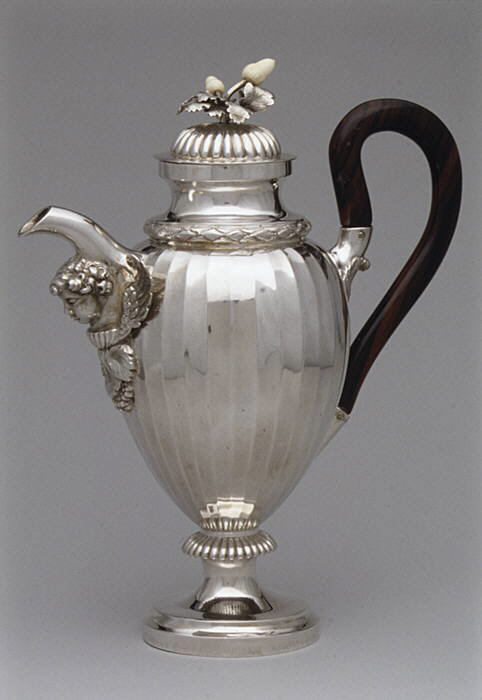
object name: coffeepot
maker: alois simpert eschenlohr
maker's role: maker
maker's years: 1785-1837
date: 1823-1824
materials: wood, ivory, silver